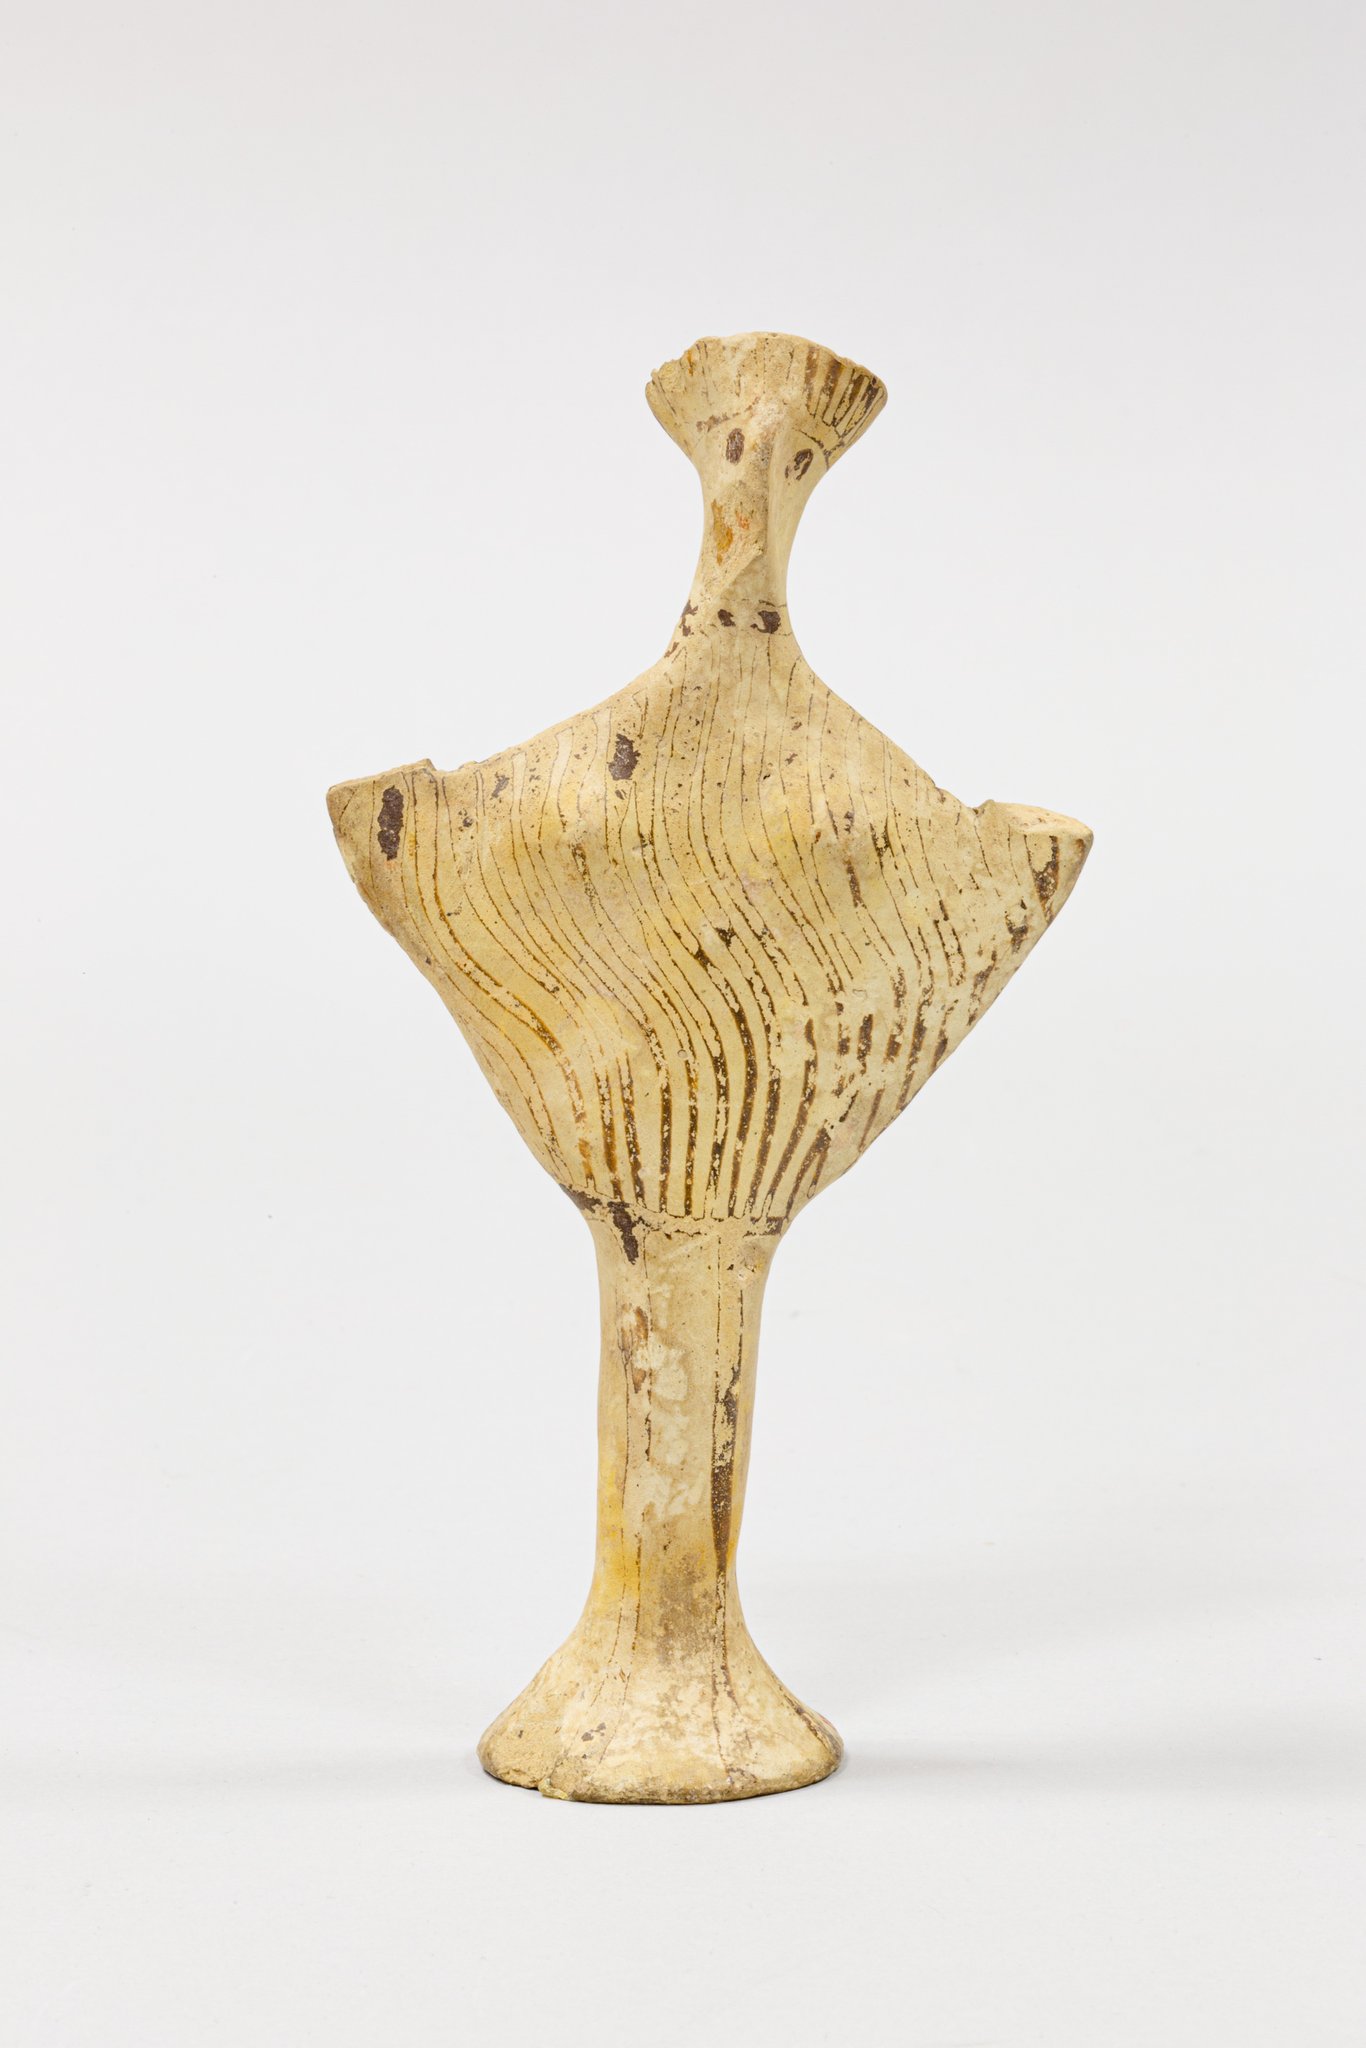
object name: statuette of a woman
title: Terracotta female figure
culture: aegean, helladic or mycenaean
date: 1300-1200 BCE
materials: terracotta